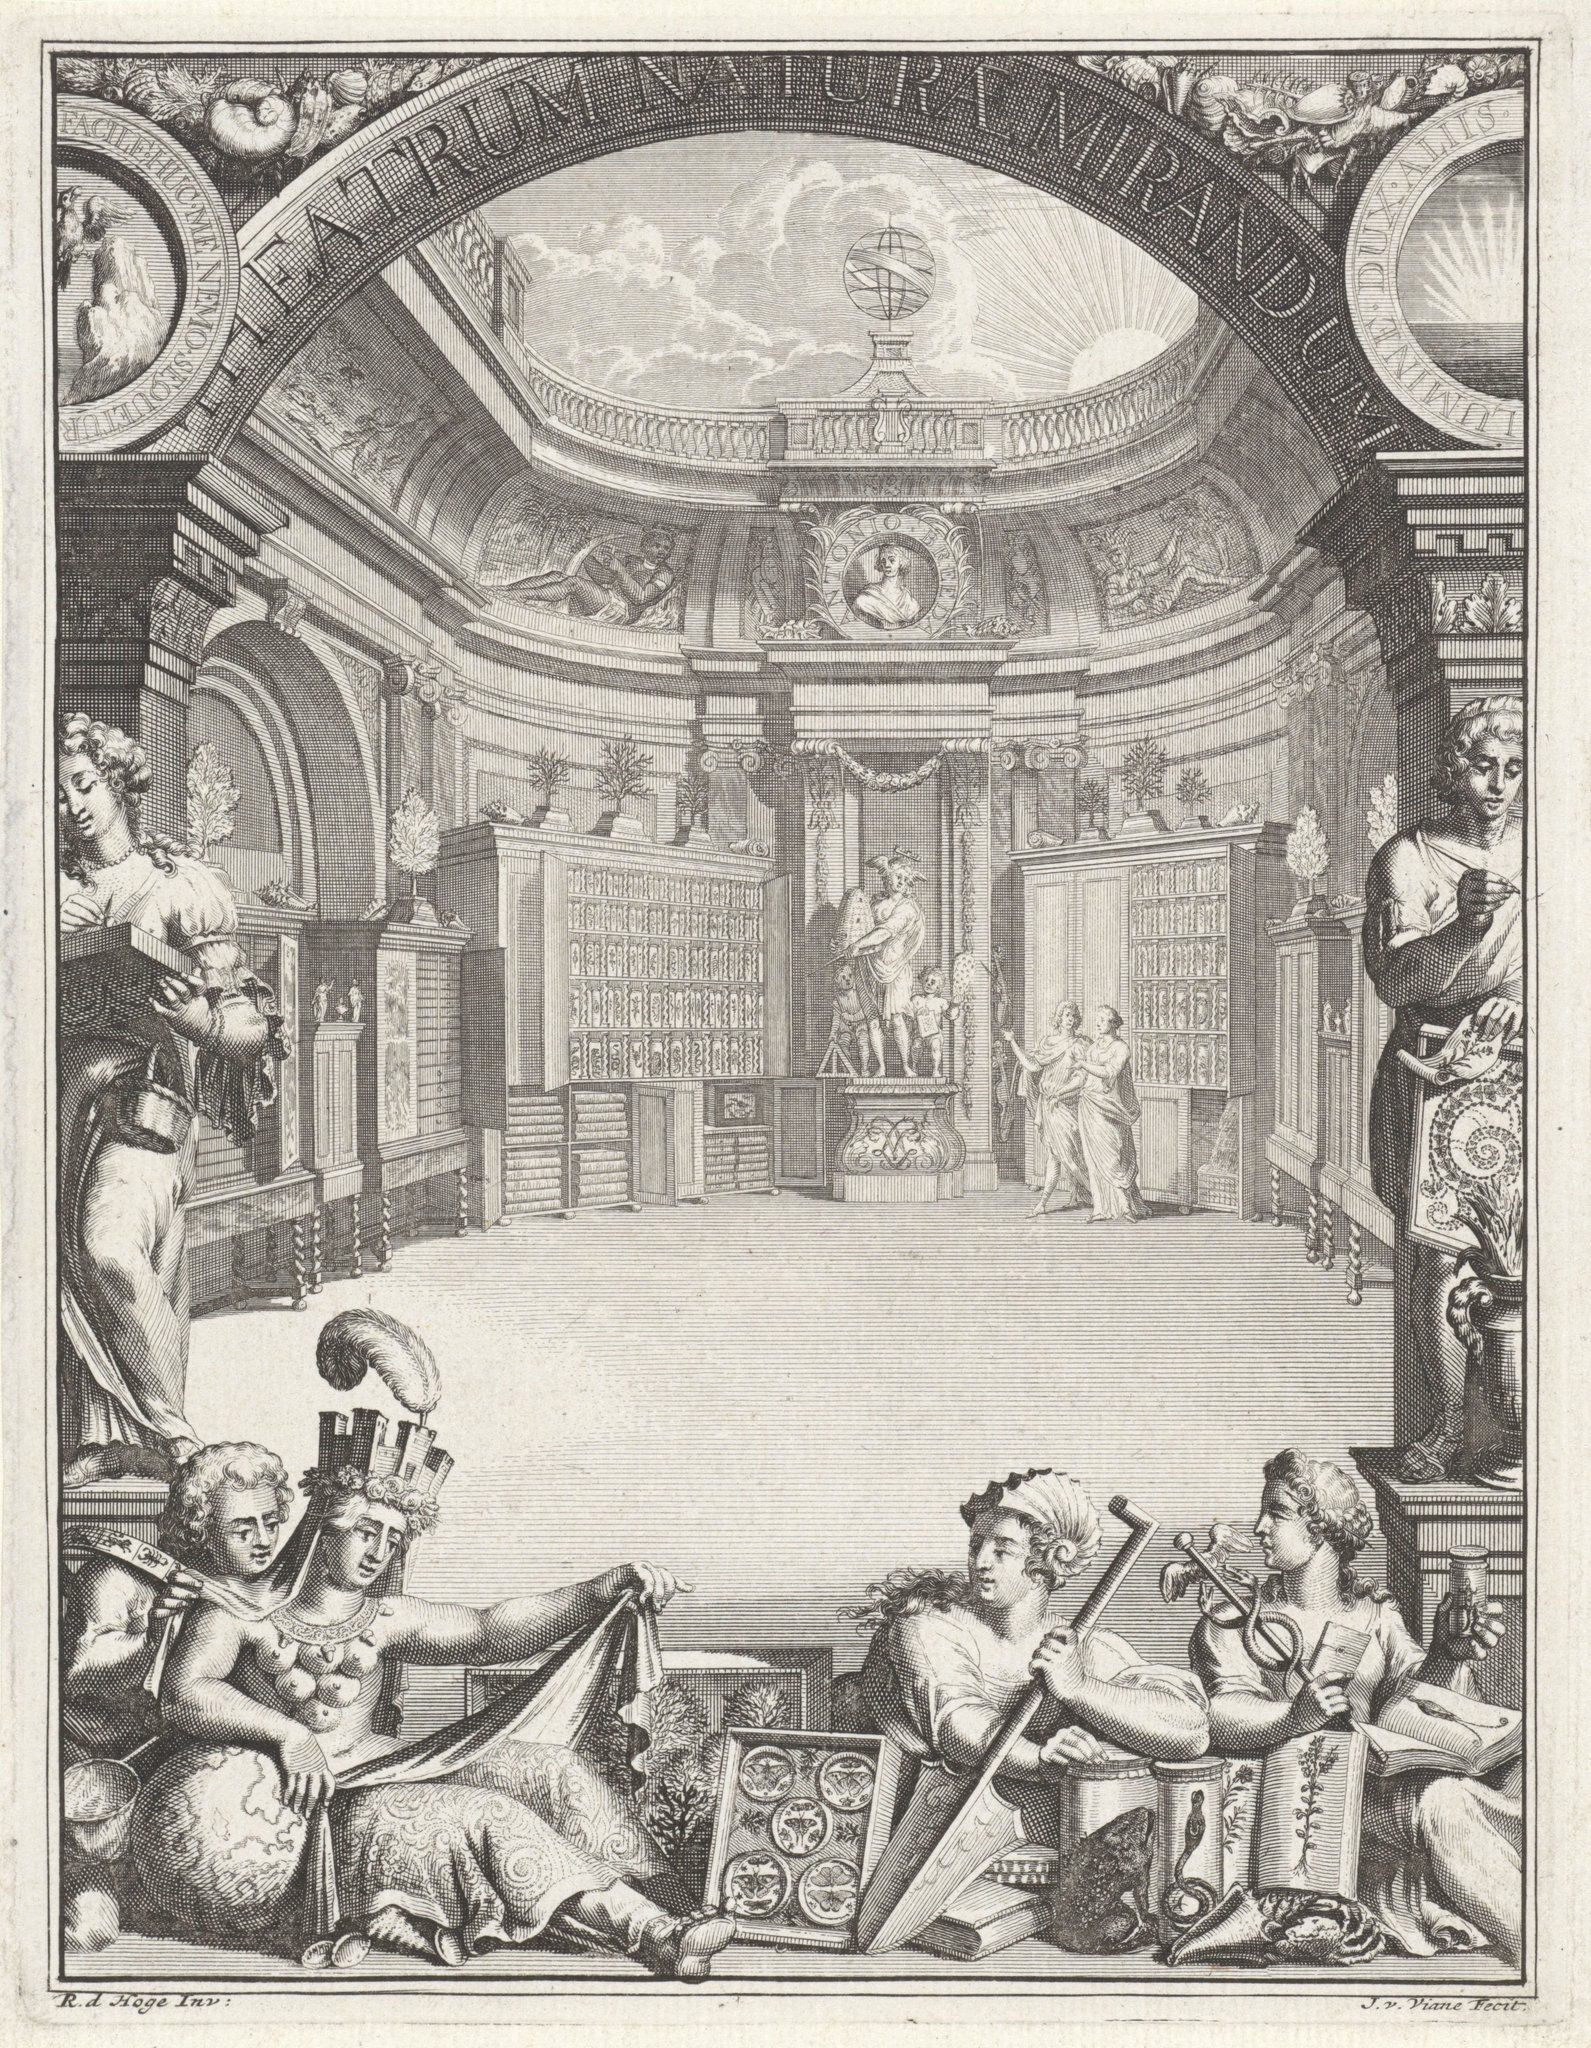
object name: print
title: Paar in een naturaliakabinet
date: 1706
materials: paper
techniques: engraving, etching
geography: amsterdam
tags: 'natura' (allegorical figure or scene; or as diana of ephesus, with many breasts); 'natura' (ripa), cabinet of curiosities, 'kunst- und wunderkammer'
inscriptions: collector's mark: Lugt 2228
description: Een paar in een interieur met kasten met boeken en potten met dieren op sterk water. Op de kasten schelpen en planten. Op de voorgrond allegorische figuren met vlinders, reptielen, schelpen, en boeken met afbeeldingen van planten. Links een zittende vrouwelijke figuur met meerdere borsten, als allegorie op de natuur, leunende op een aardglobe.